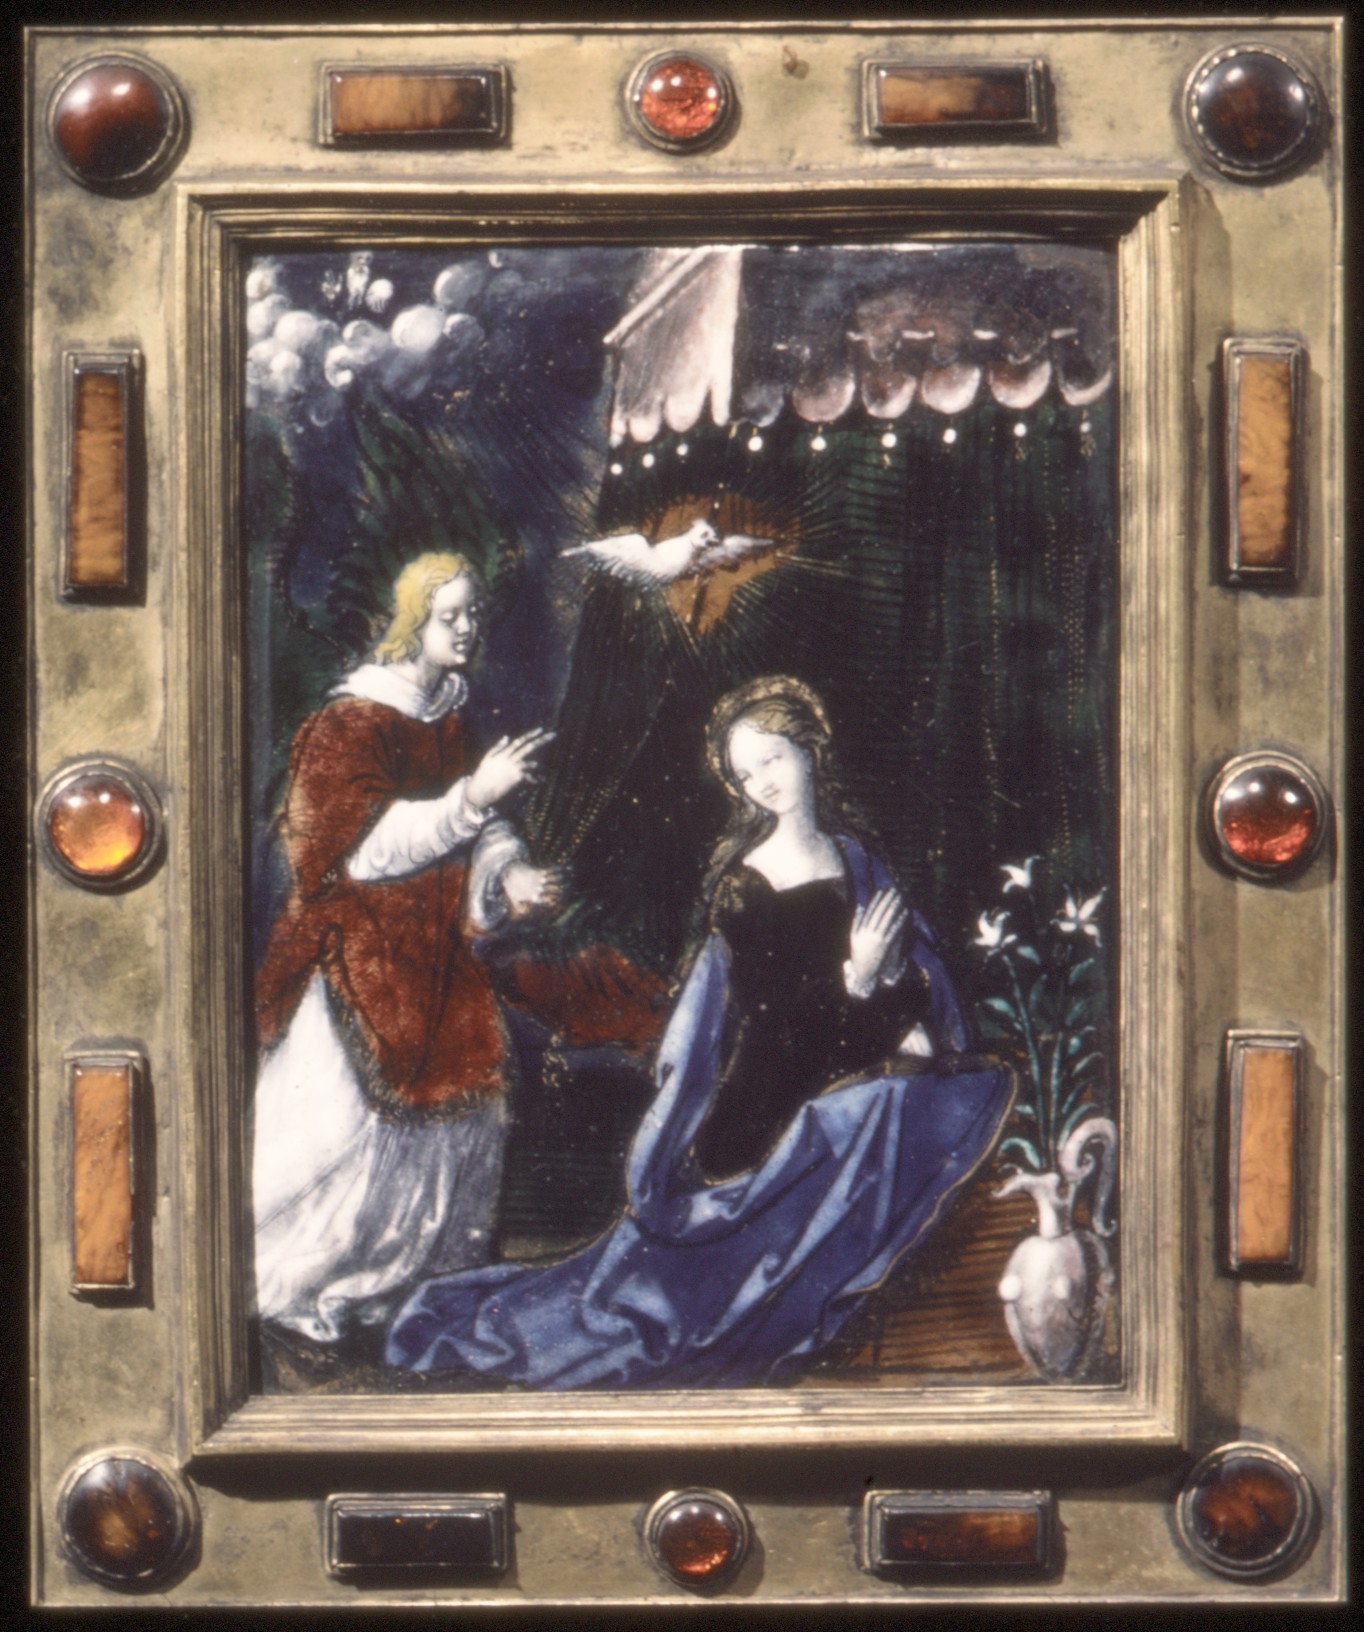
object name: plaque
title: The Annunciation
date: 1851-1900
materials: copper, enamel, gilt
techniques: painting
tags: birds,men,virgin mary,annunciation